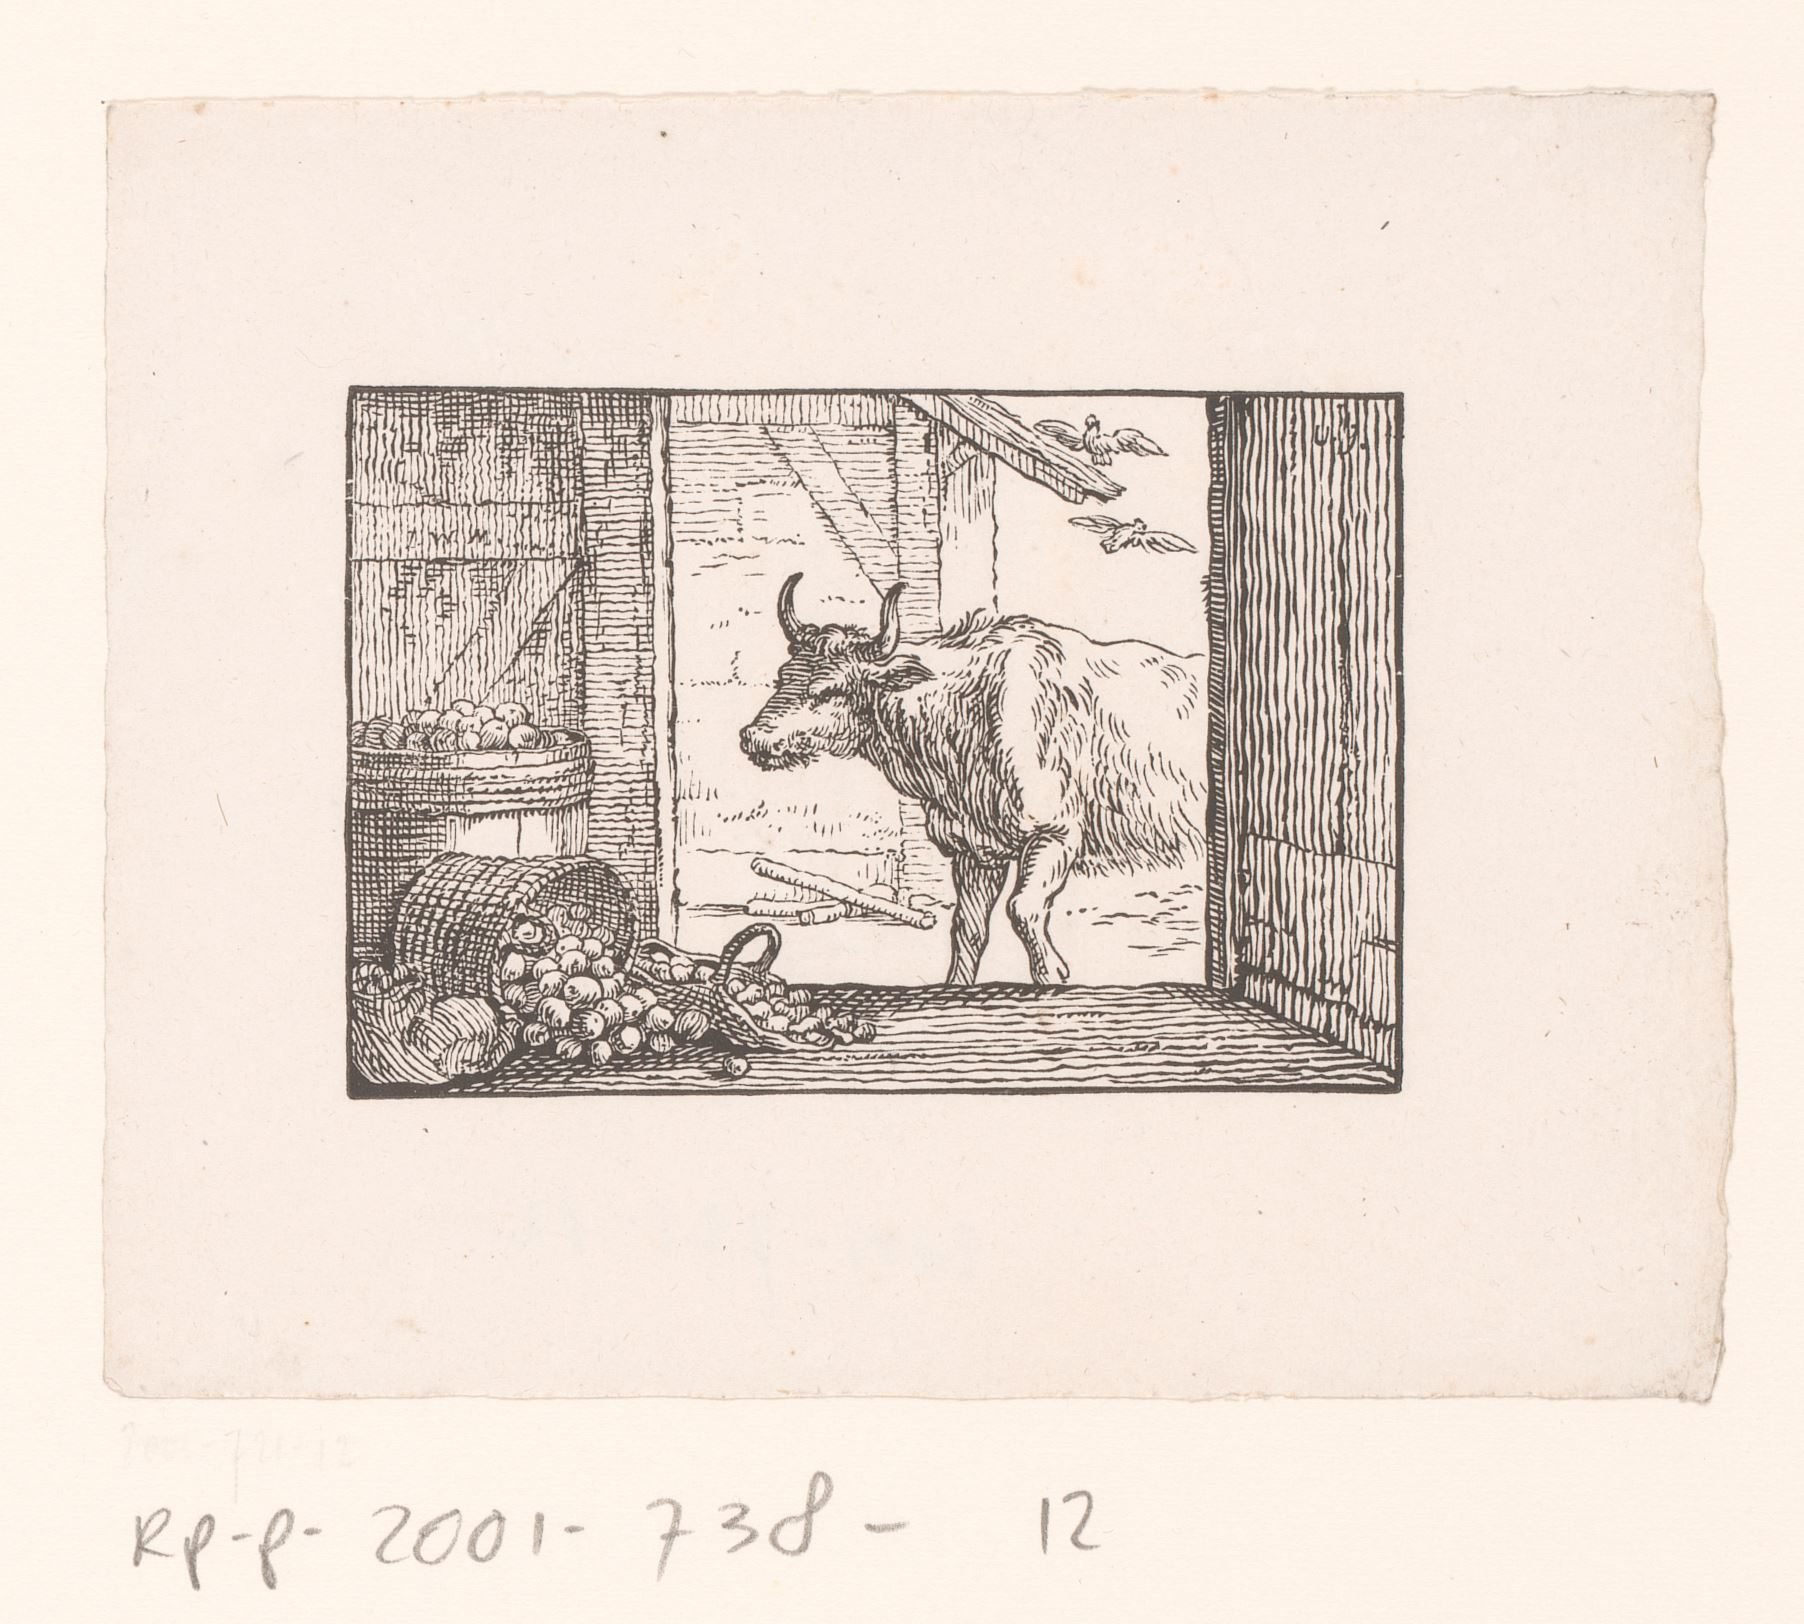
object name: print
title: Koe loopt schuur in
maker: johann friedrich gottlieb unger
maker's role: print maker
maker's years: 1753-1804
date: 1763-1804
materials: paper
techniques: woodcut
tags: cow, animals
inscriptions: collector's mark: Lugt 2228